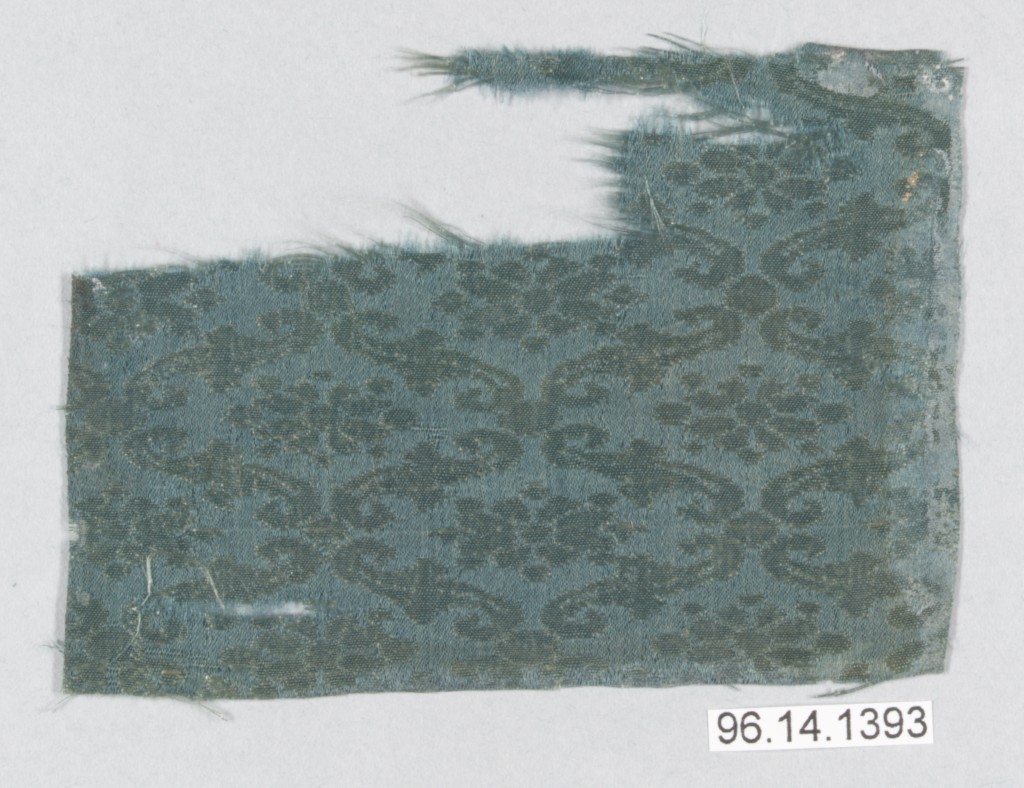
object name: piece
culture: japanese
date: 1701-1900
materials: silk